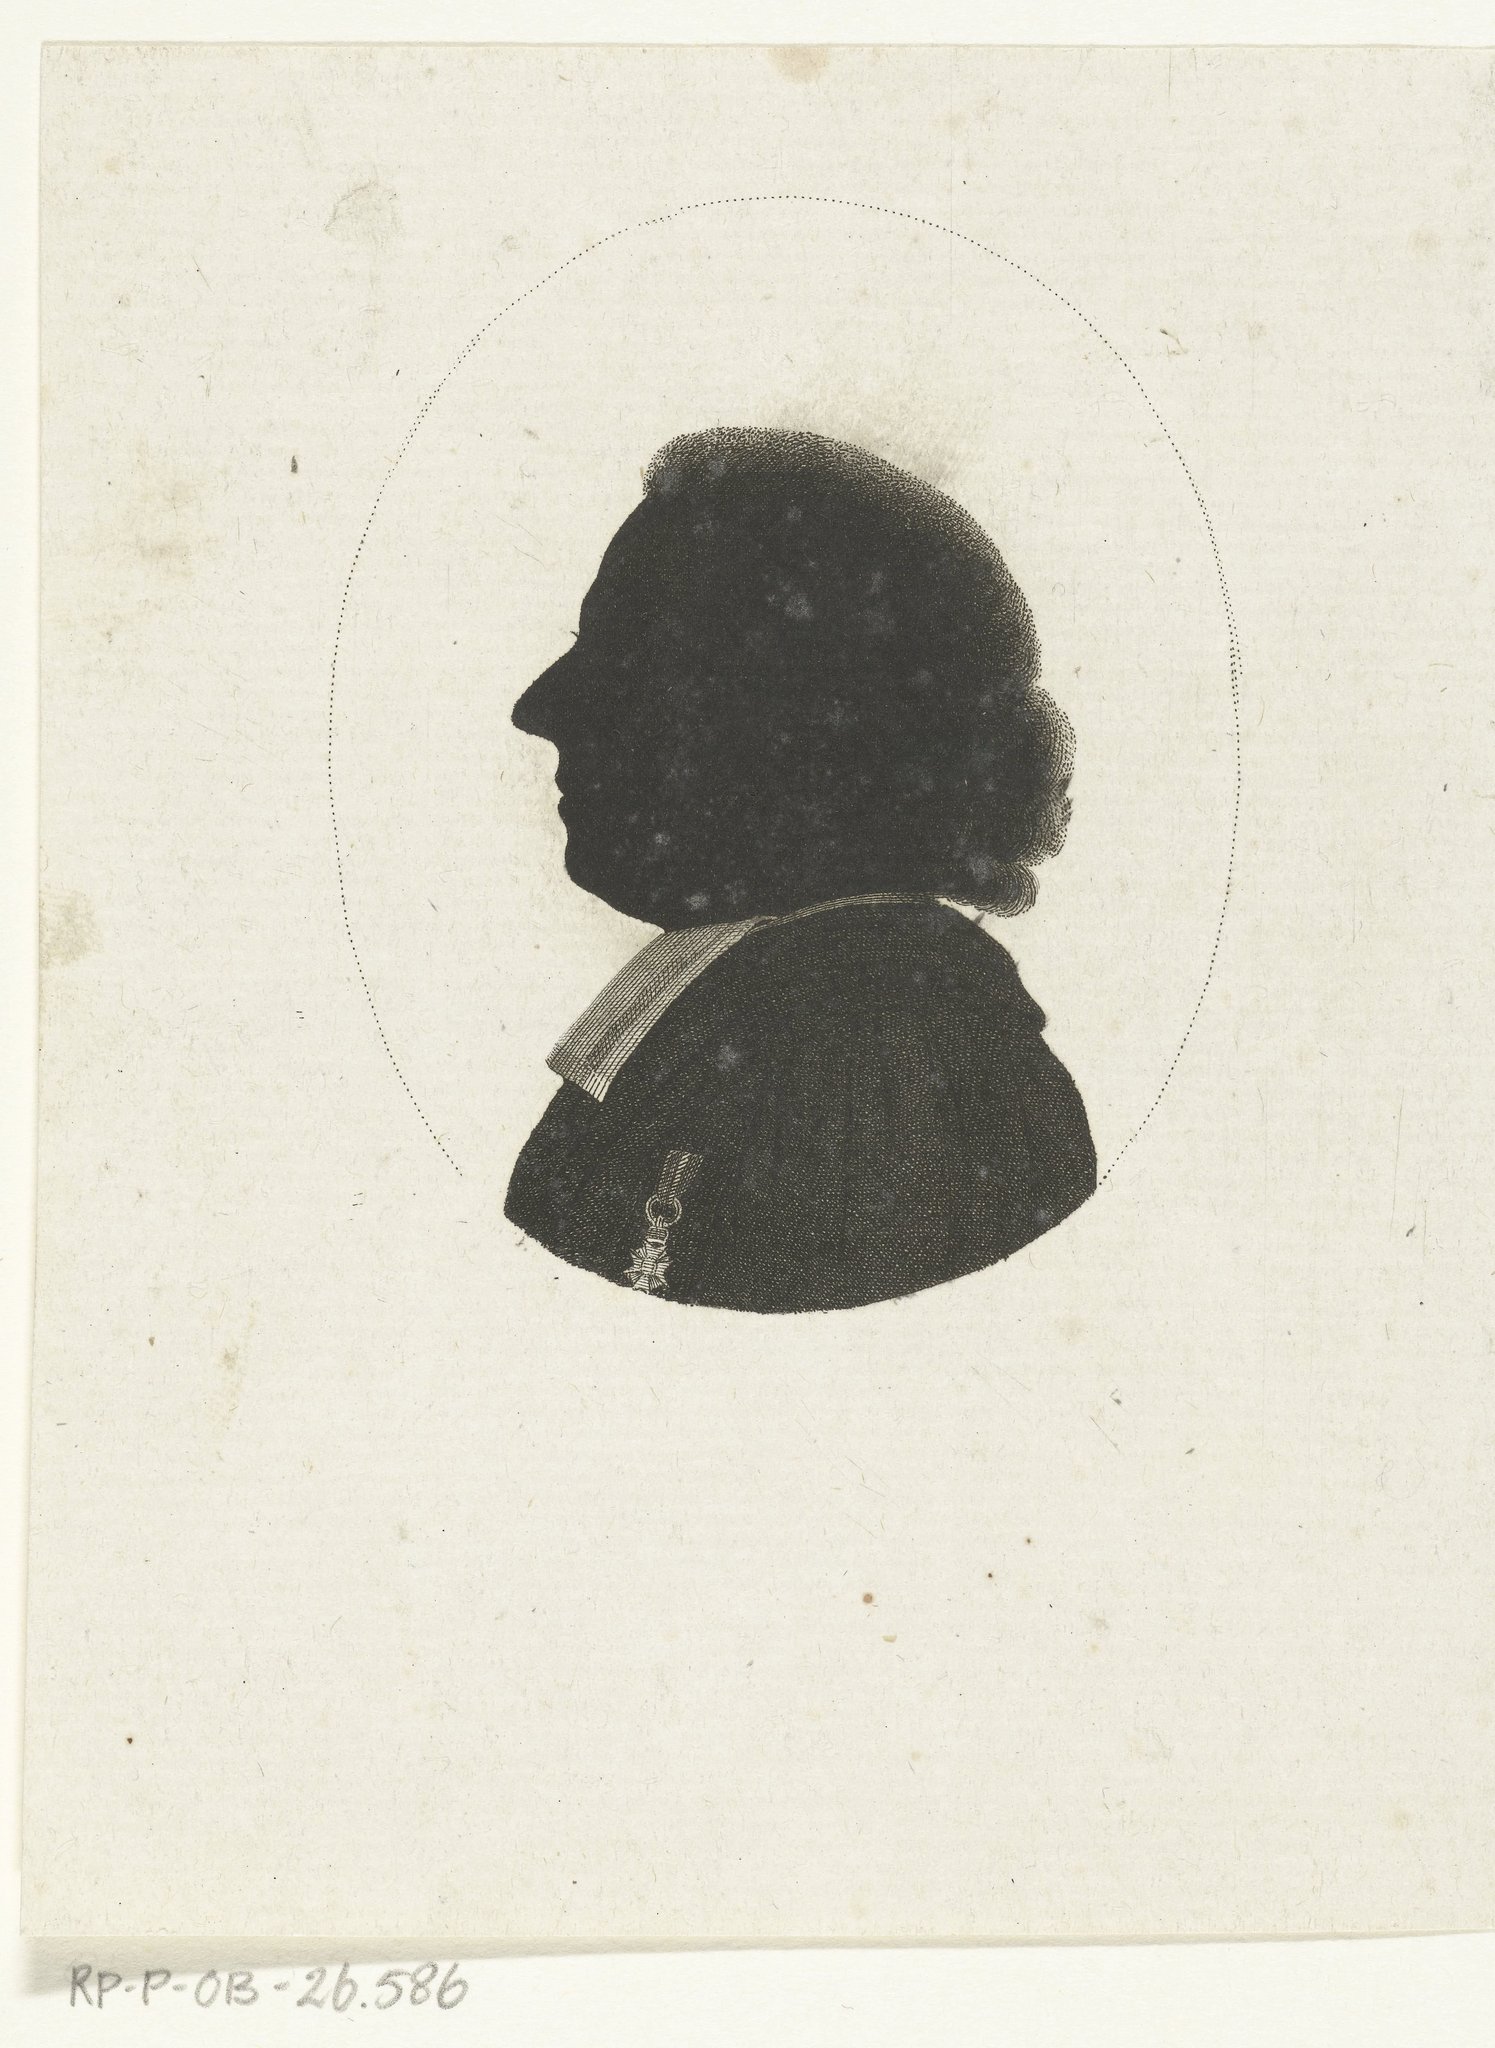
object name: print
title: Silhouetportret van onbekende predikant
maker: johannes christiaan bendorp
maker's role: print maker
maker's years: 1766-1849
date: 1776-1849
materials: paper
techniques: etching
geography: netherlands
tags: functionaries and dignitaries (with name) ~ episcopal protestant churches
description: Buste in silhouet van onbekende predikant, opvallend detail op de zwarte kleding is de onderscheiding in de vorm van een lintje met kruis.